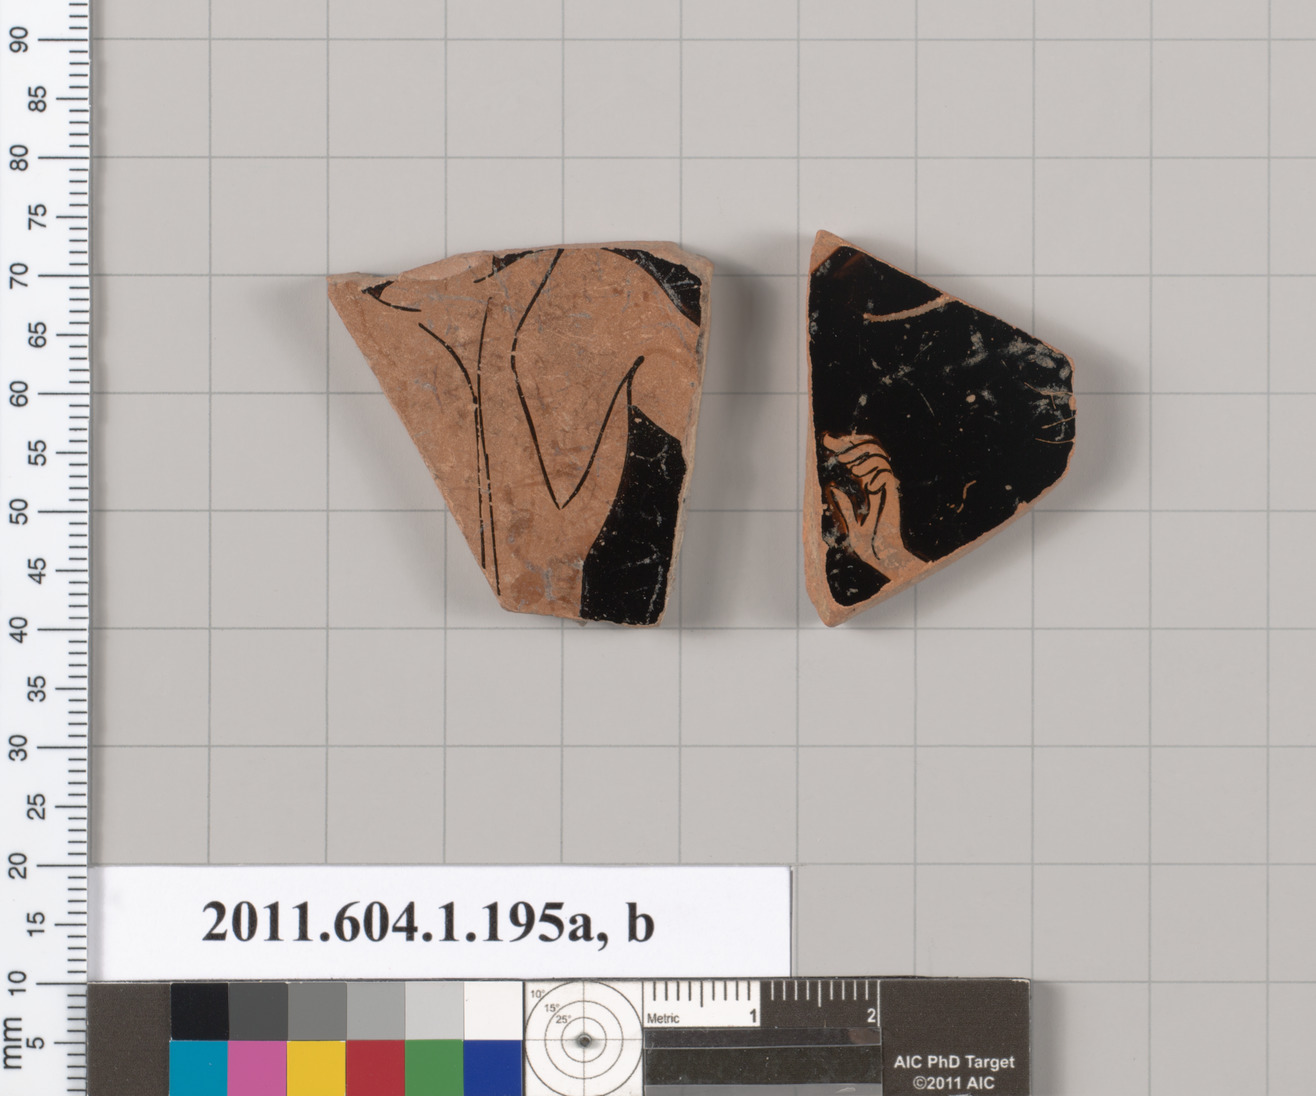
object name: kylix fragment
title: Terracotta fragments of a kylix (drinking cup)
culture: greek, attic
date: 475-451 BCE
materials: terracotta